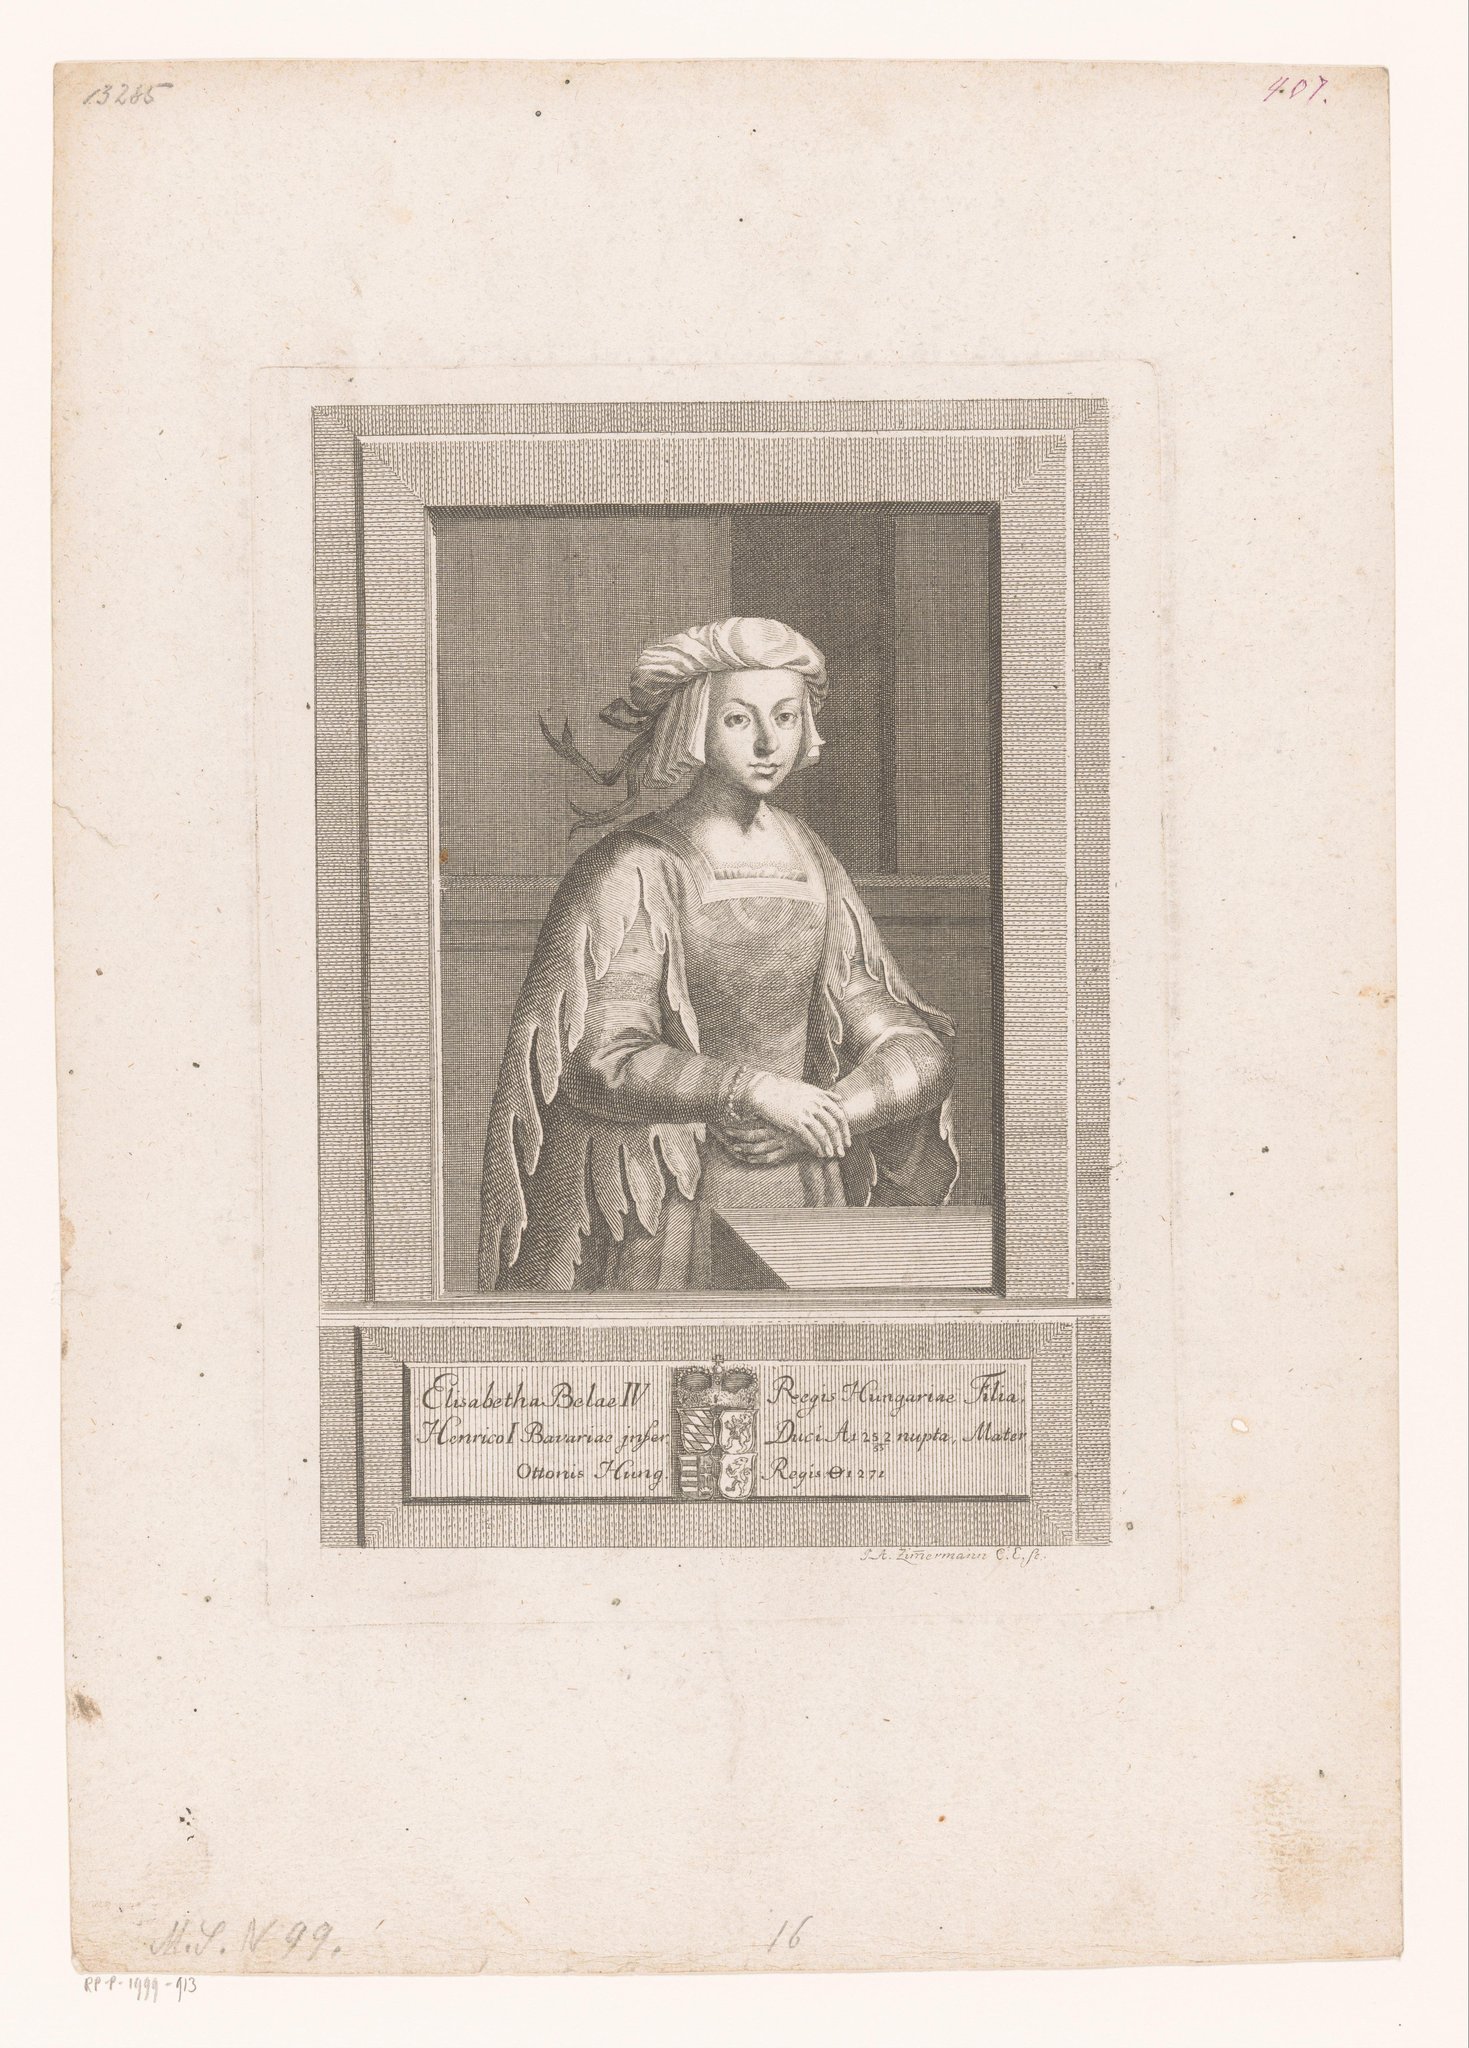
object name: print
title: Portret van Elisabeth van Hongarije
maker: joseph anton zimmermann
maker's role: draughtsman, print maker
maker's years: 1705-1797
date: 1773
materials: paper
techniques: engraving, etching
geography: germany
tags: historical persons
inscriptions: collector's mark: Lugt 4100, collector's mark: Lugt 2228, collector's mark: Lugt 1238, collector's mark: Lugt 2760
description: Prent gebruikt voor de publicatie: Zimmermann, Joseph Anton. Series Imaginum Augustae Domus Boicae. München: s.n., 1773.